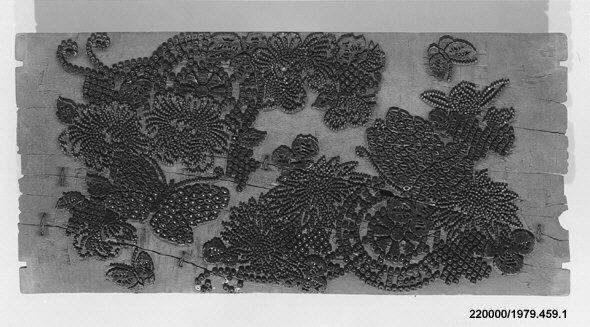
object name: pressing board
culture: japanese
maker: sadahiko tabata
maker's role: artist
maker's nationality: japanese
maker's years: 19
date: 1801-1900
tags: butterflies,flowers